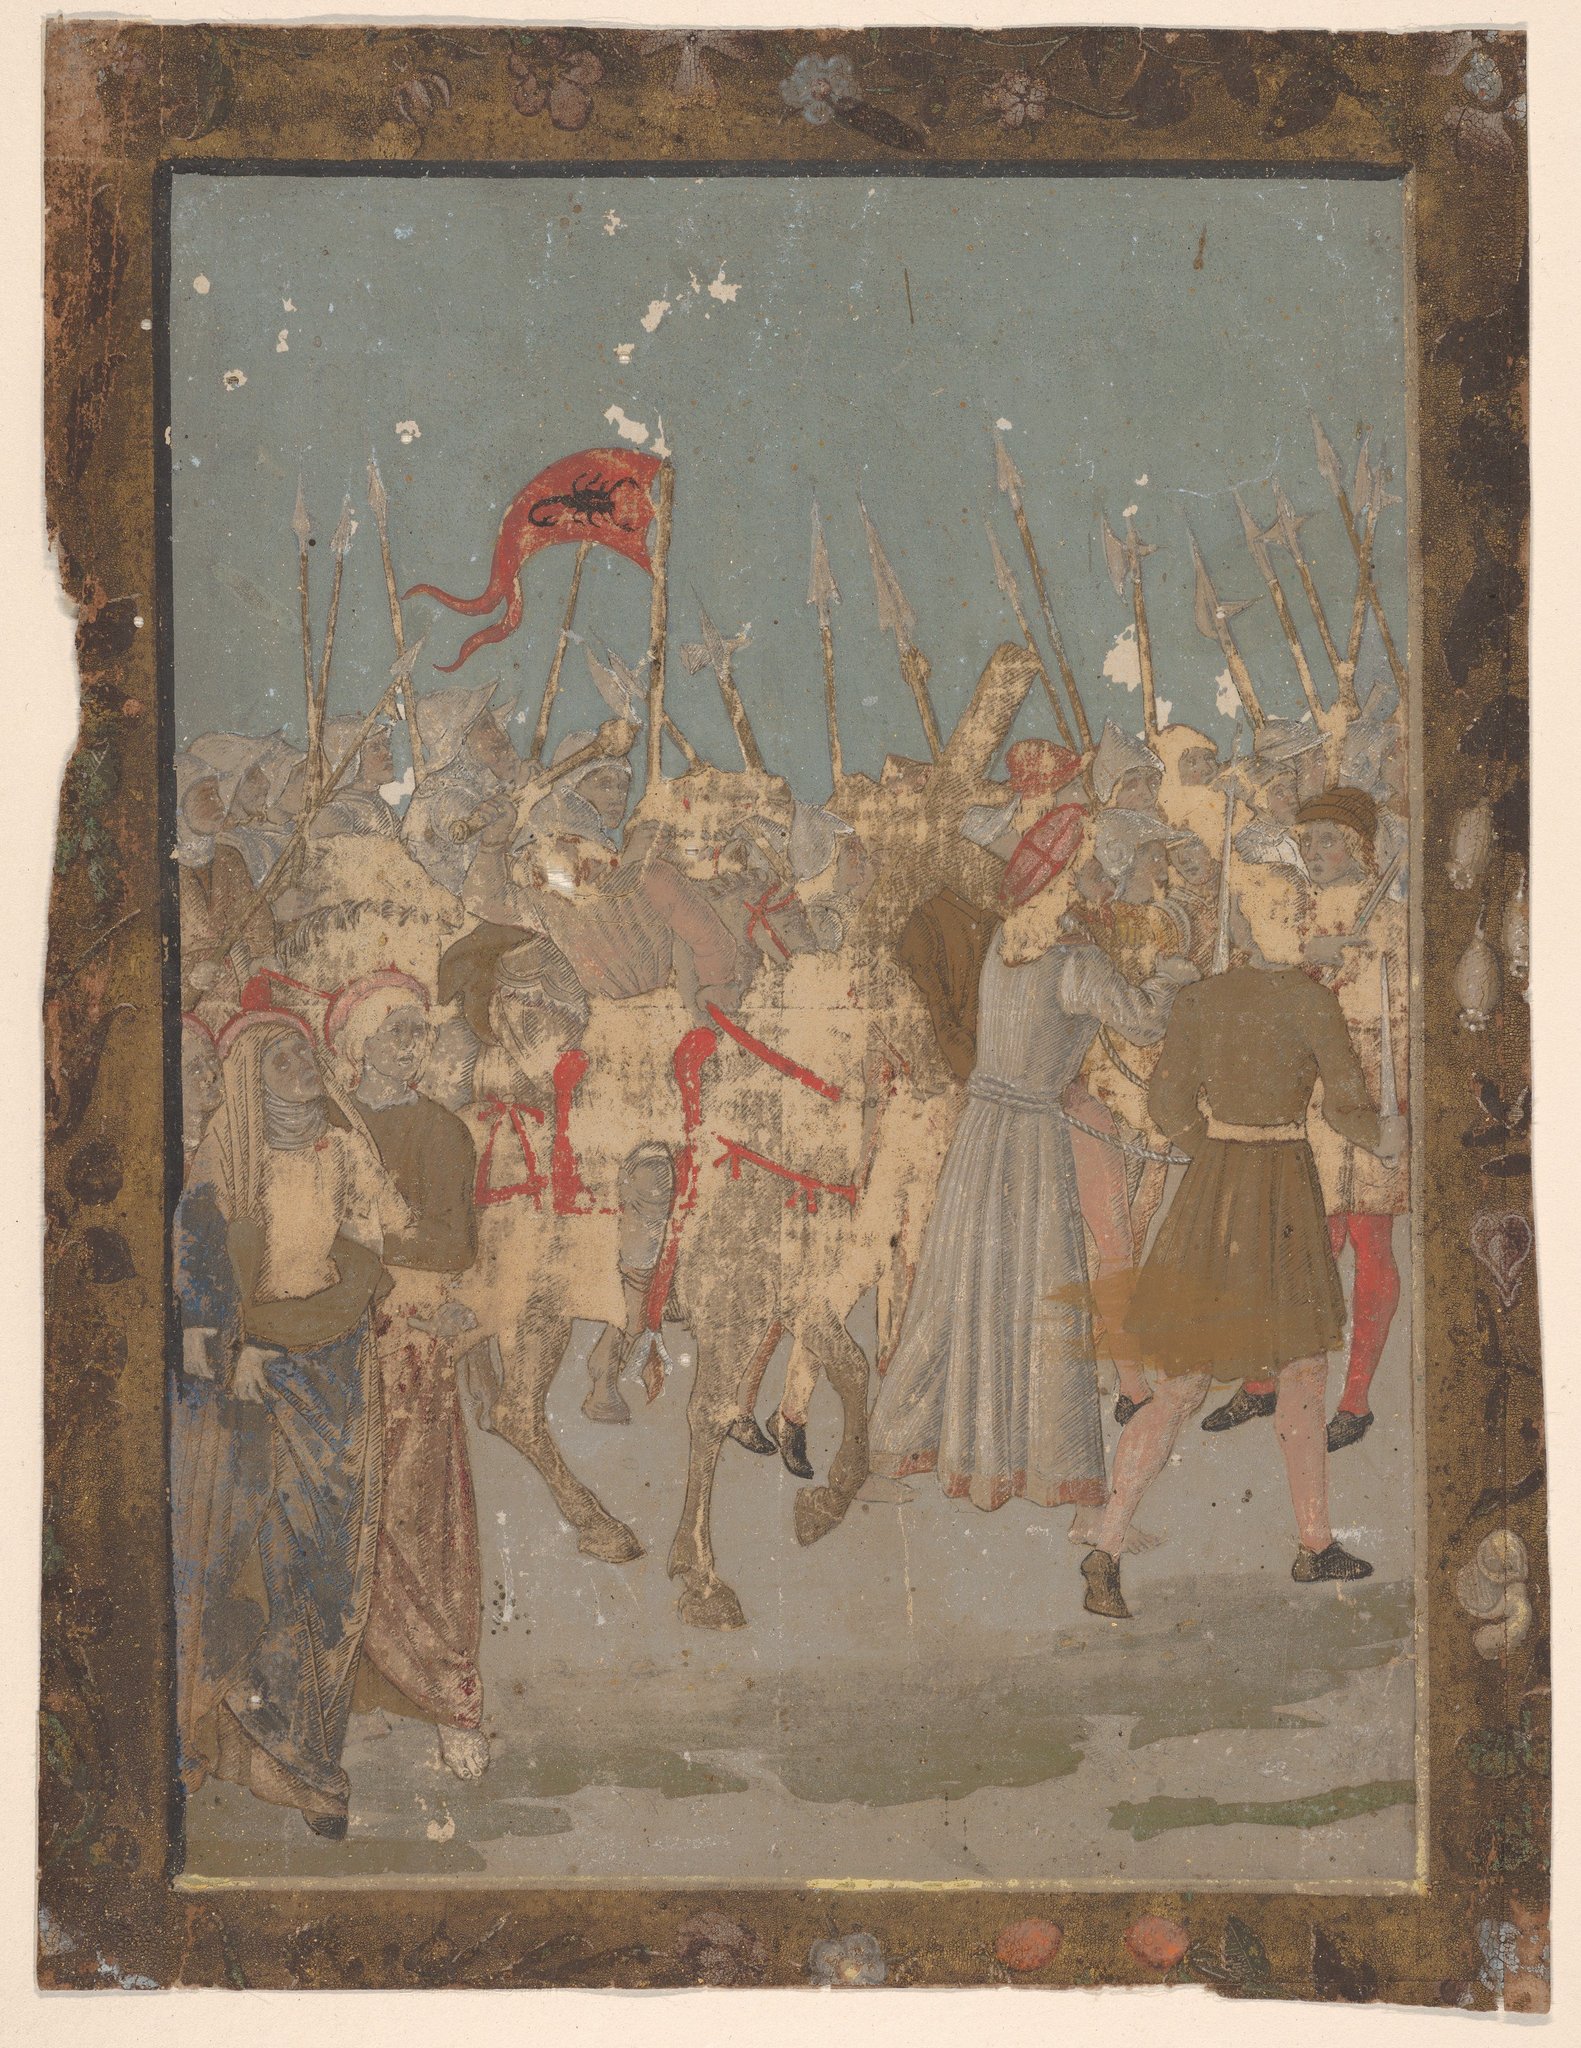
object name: print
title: The Bearing of the Cross, from Life of the Virgin and Christ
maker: francesco rosselli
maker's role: artist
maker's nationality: italian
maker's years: 1448-1527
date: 1490-1500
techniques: engraving, hand coloring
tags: weapons,christ,virgin mary,cross,crowd